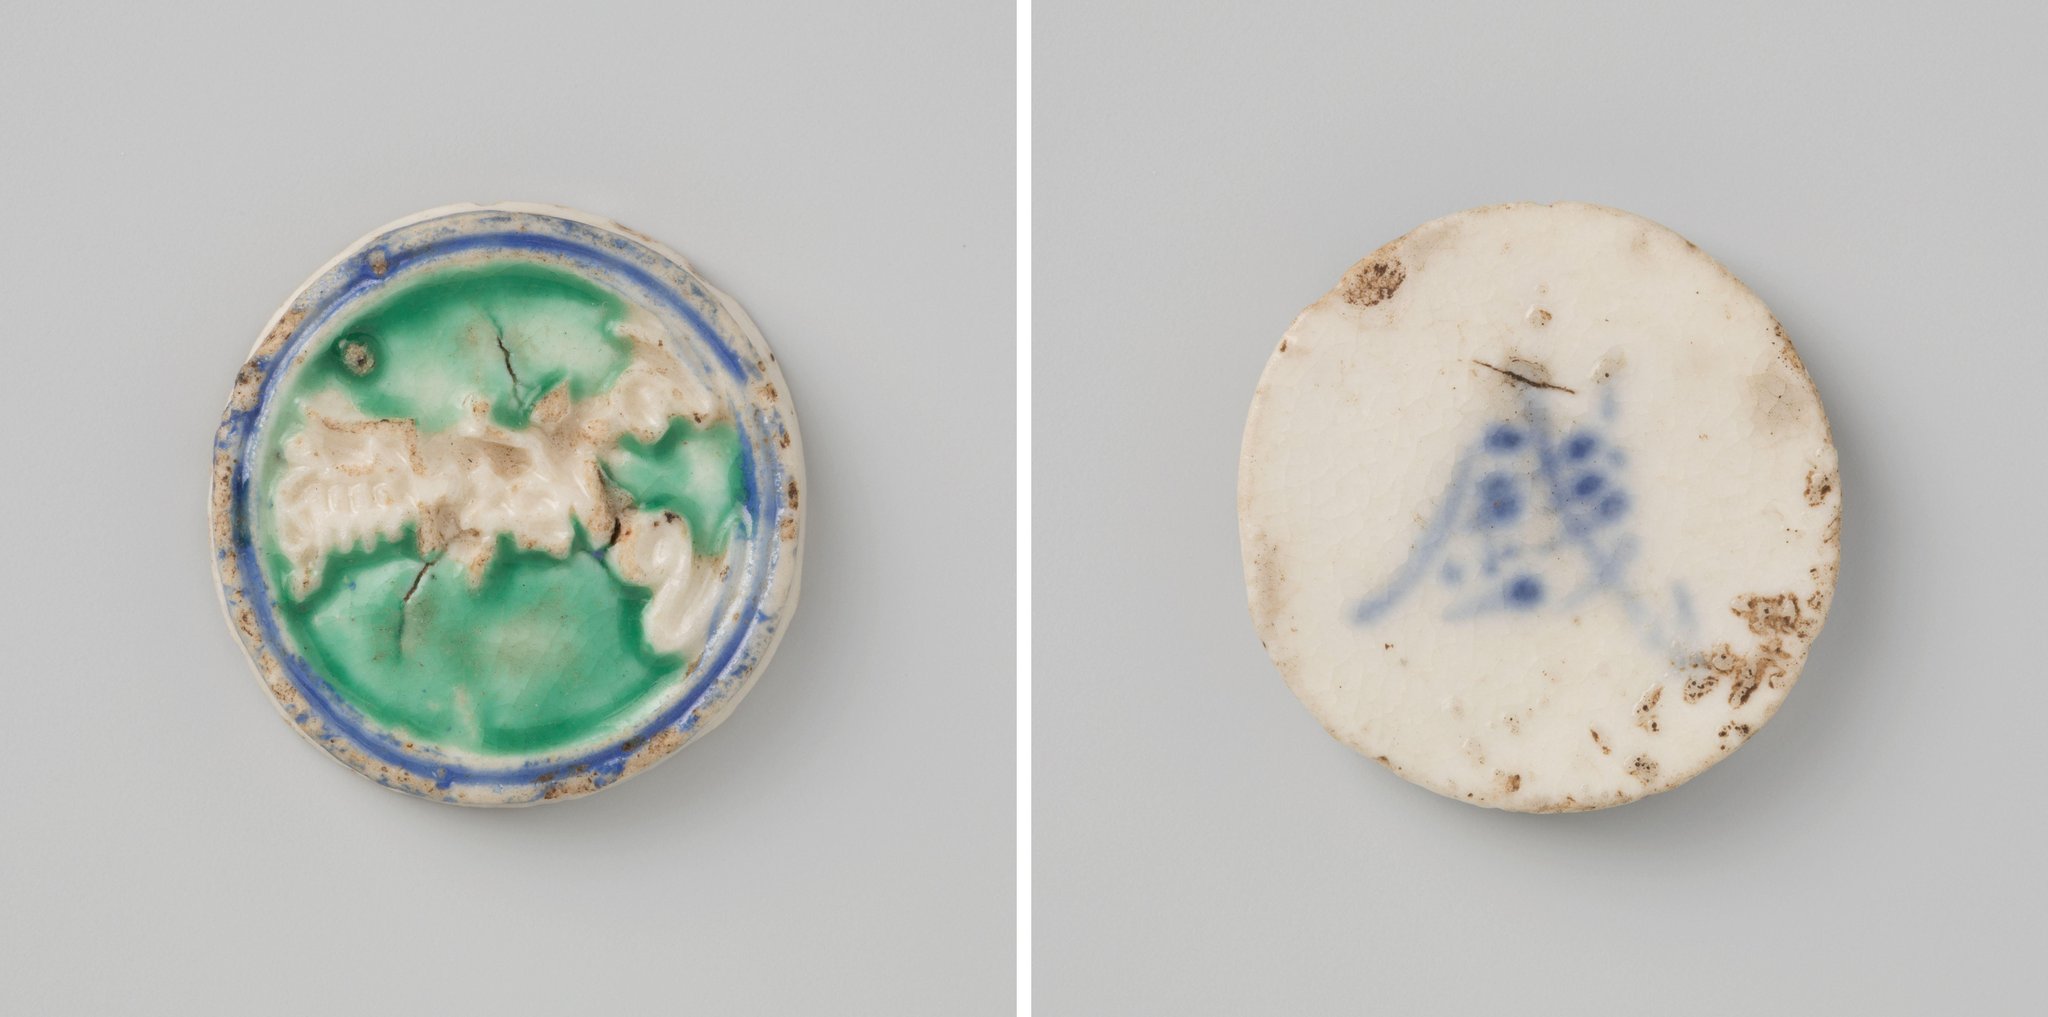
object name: coin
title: Speelhuispenning uit Thailand ter waarde van een salung, 1760-1871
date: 1760-1871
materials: porcelain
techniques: firing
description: Ronde porseleinen speelhuispenning, die ook als munt is gebruikt. Voorzijde: afbeelding van een krabof kreeft. Keerzijde: twee Chinese karakters.